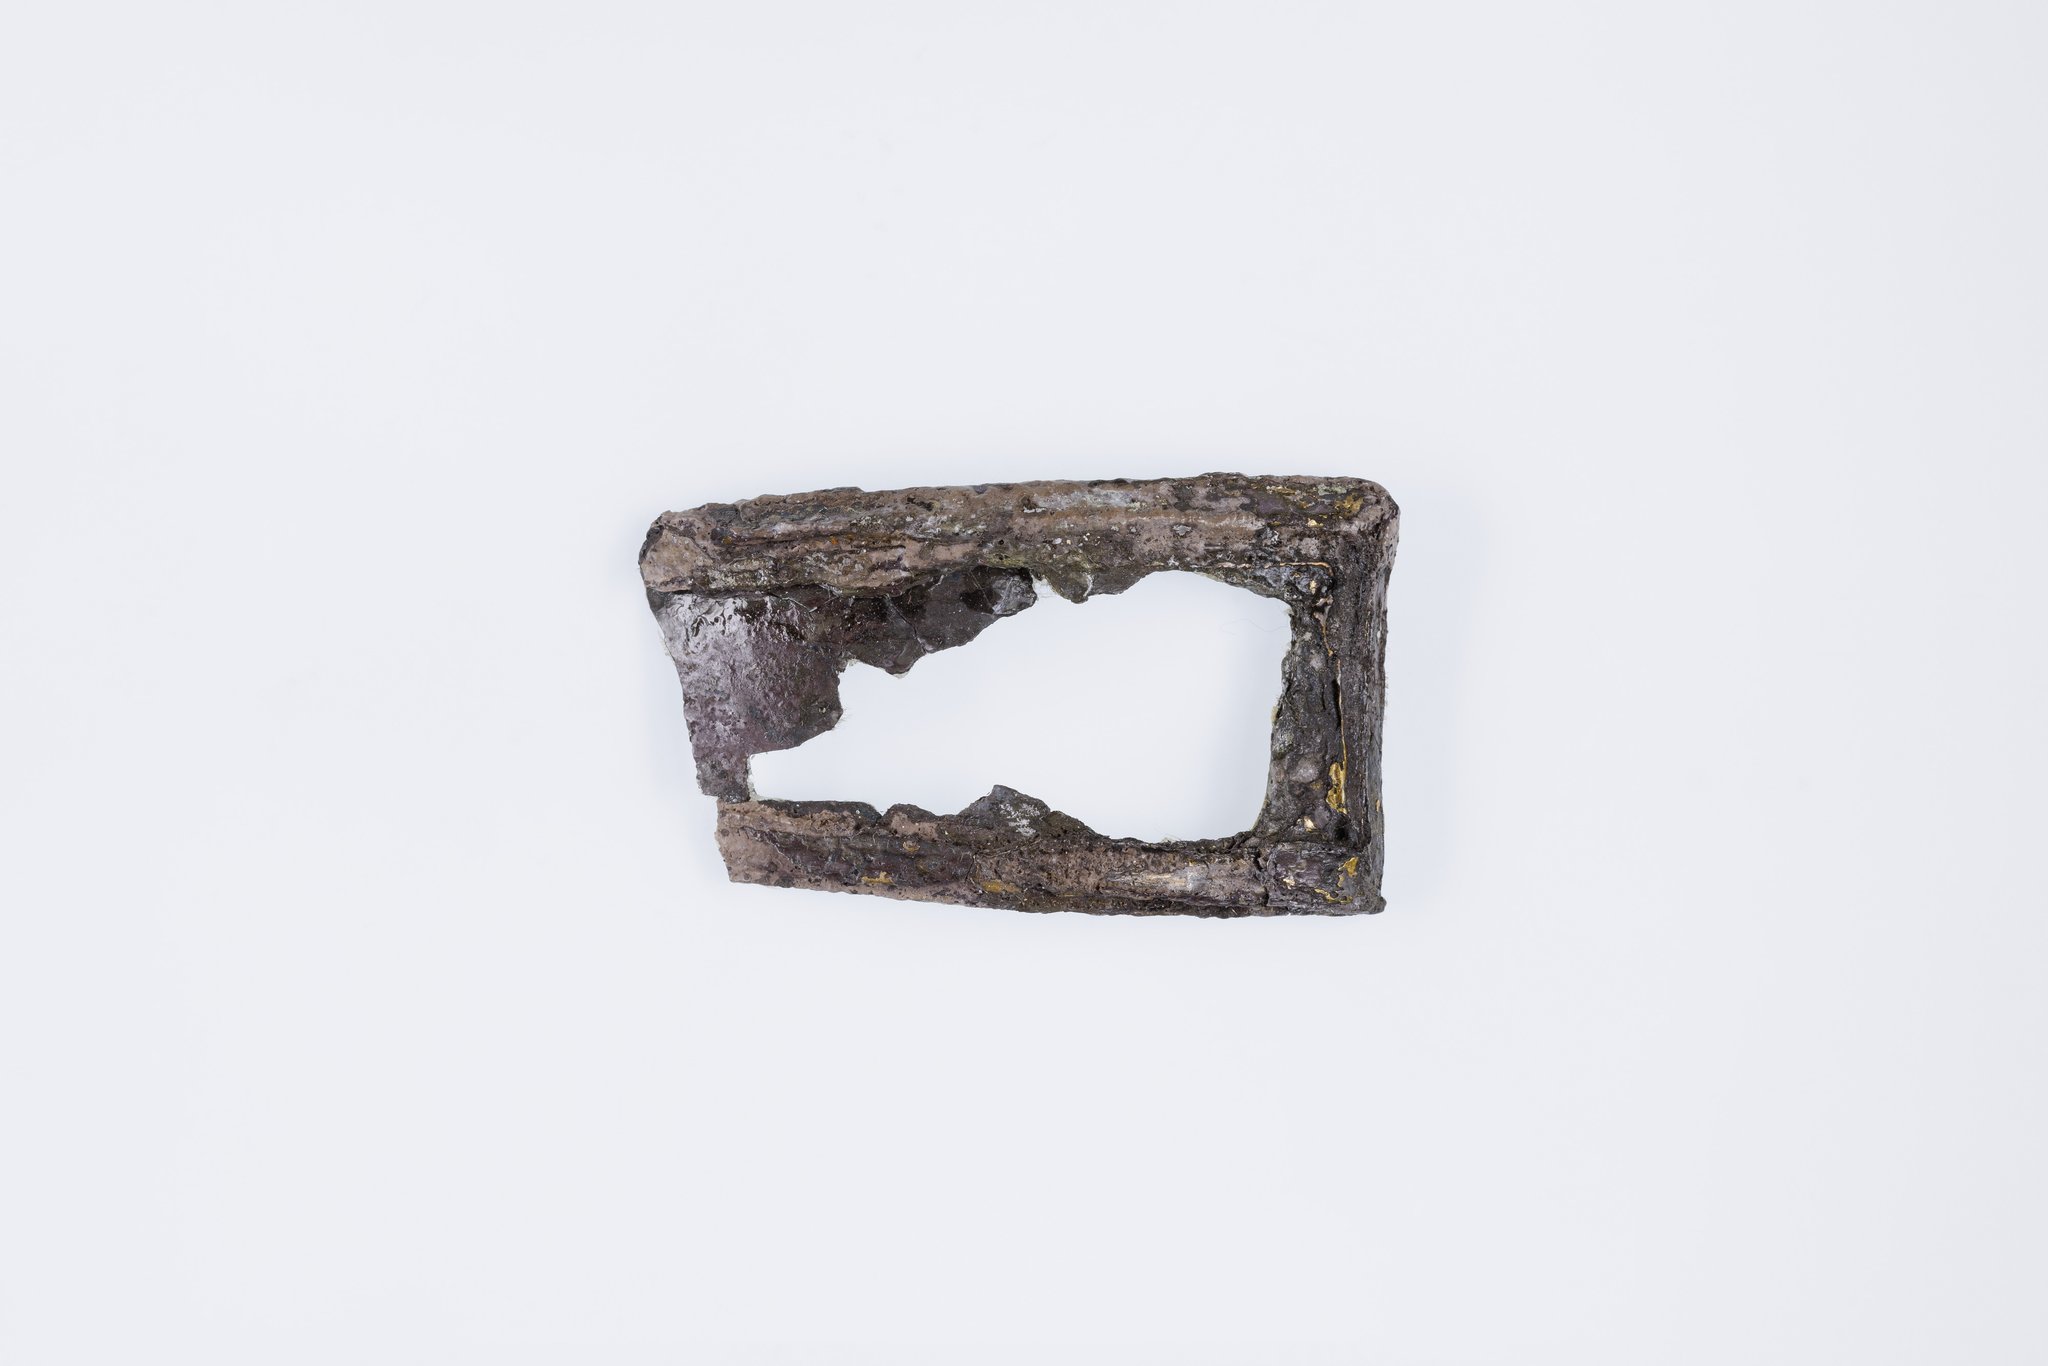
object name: frame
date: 1295-1070 BCE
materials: silver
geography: egypt